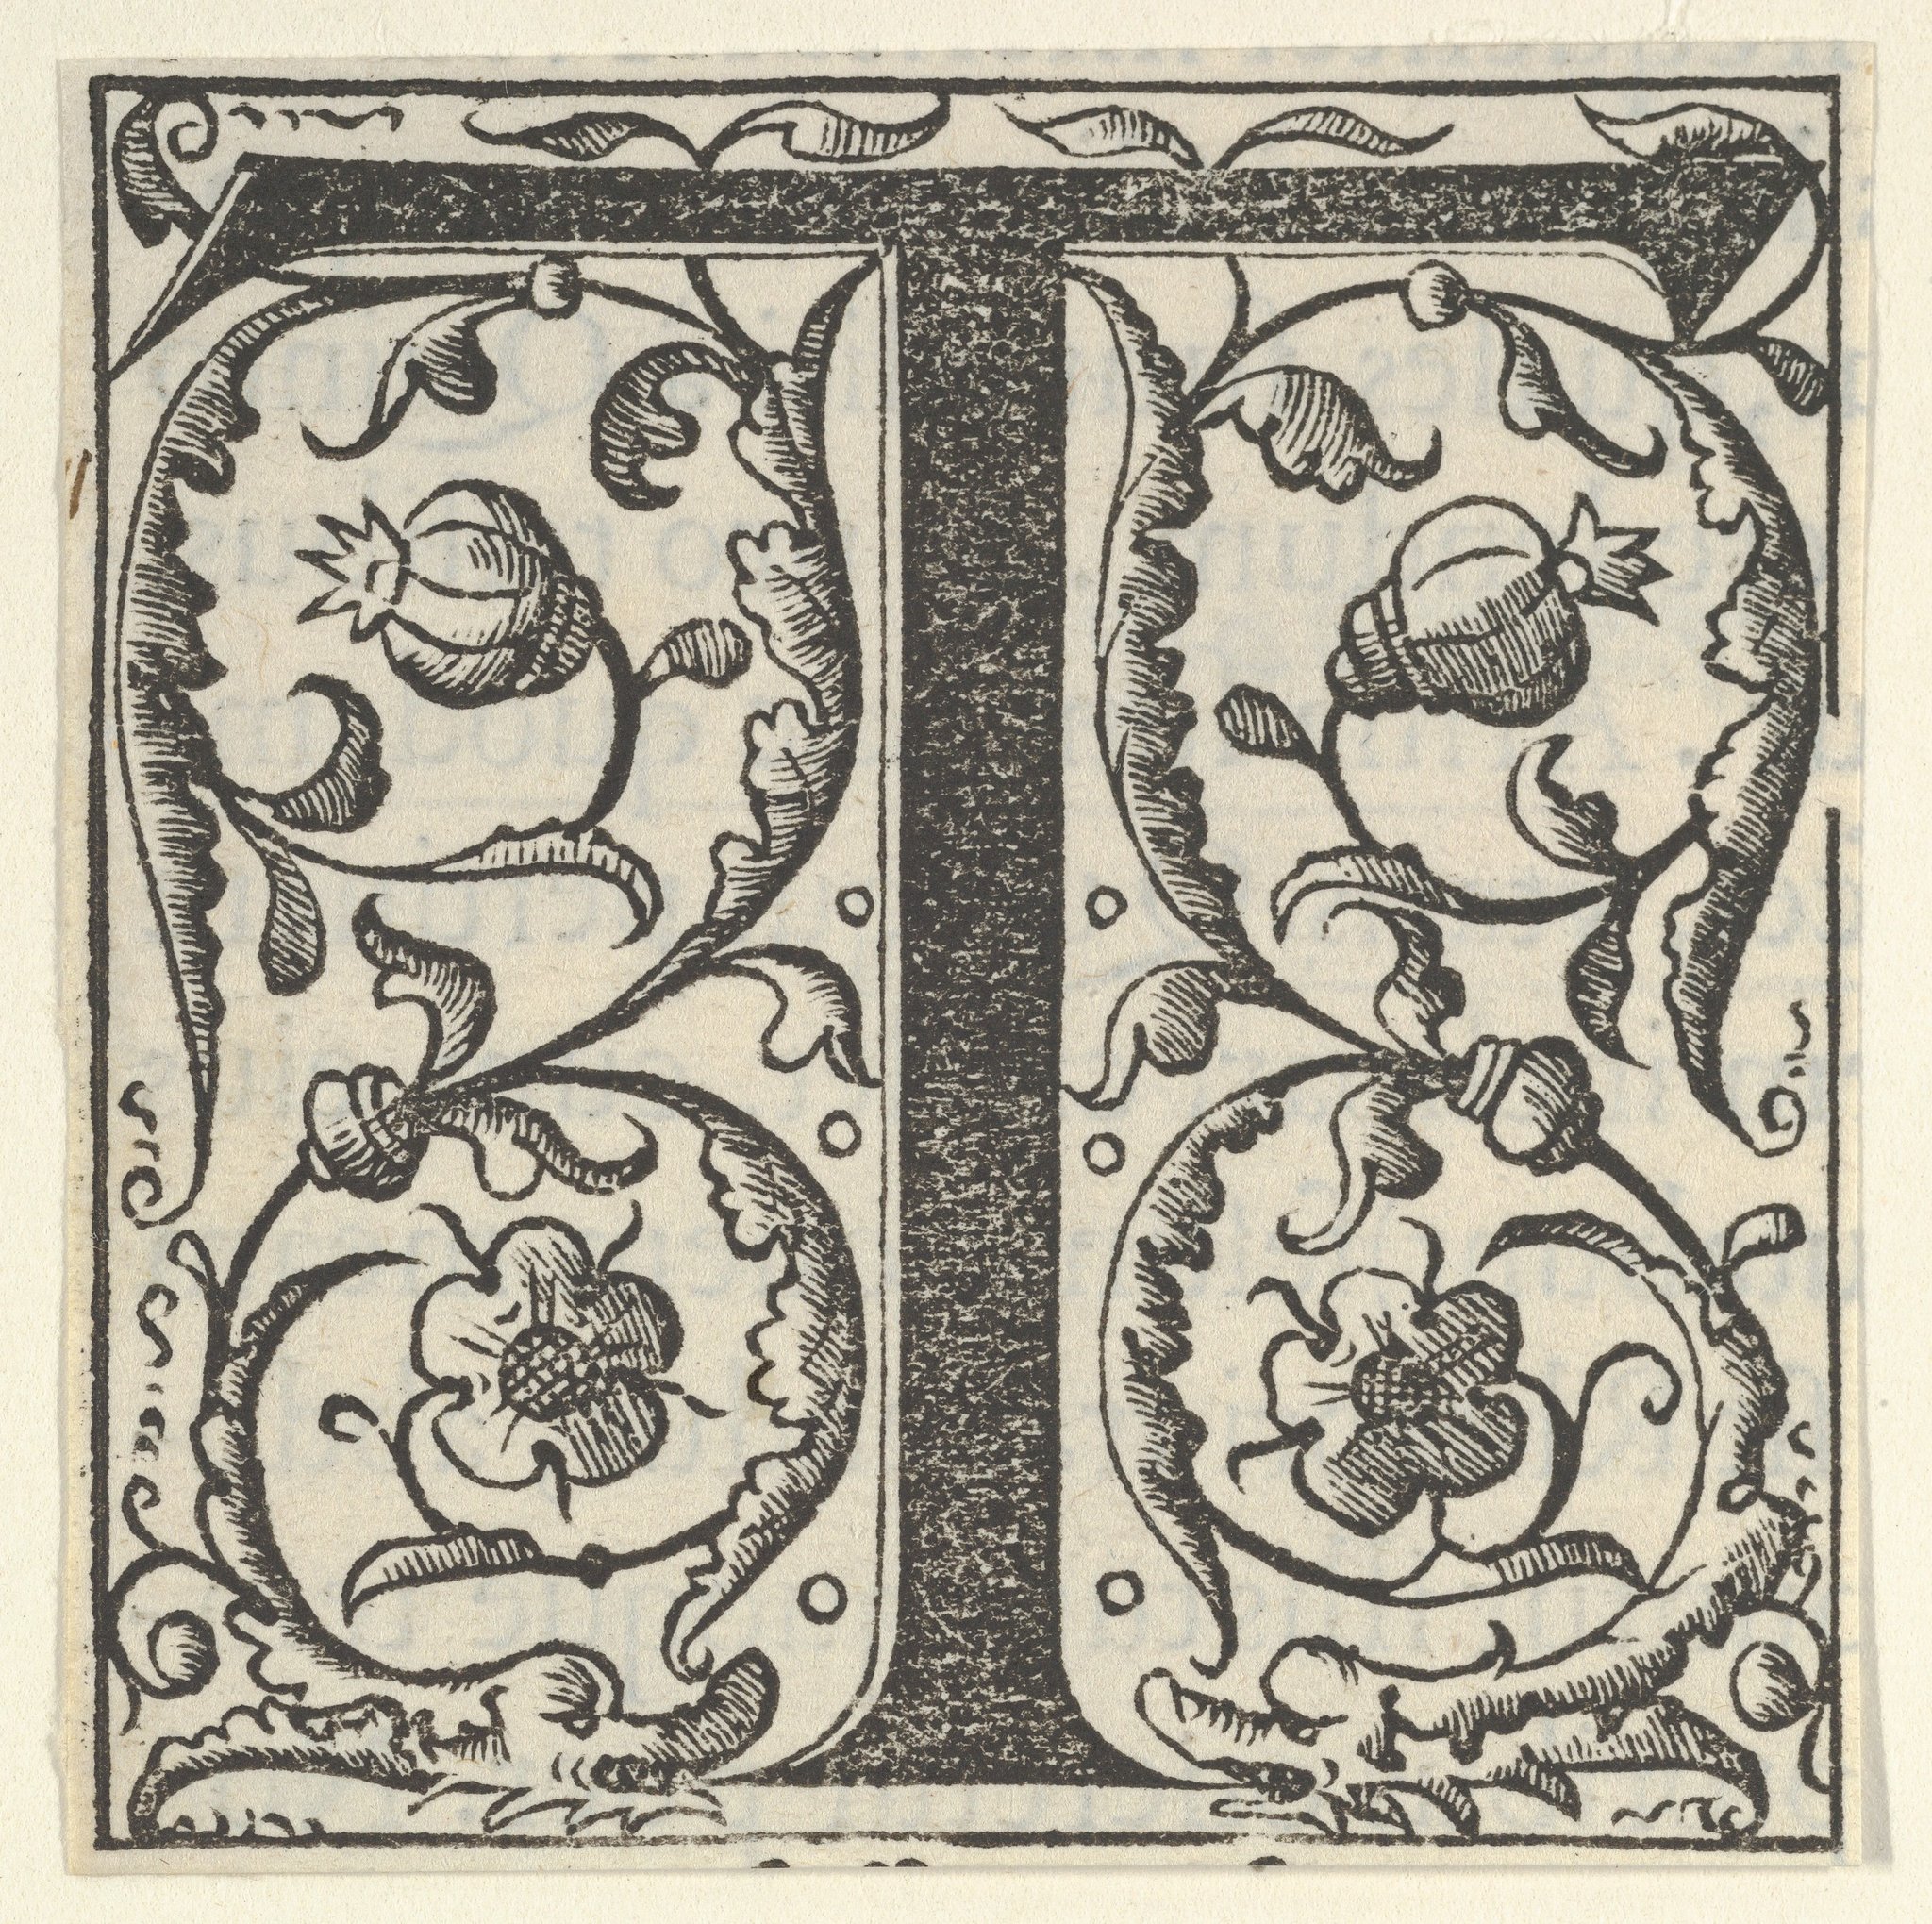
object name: print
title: Initial letter T with garlands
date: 1534-1566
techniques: woodcut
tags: garlands